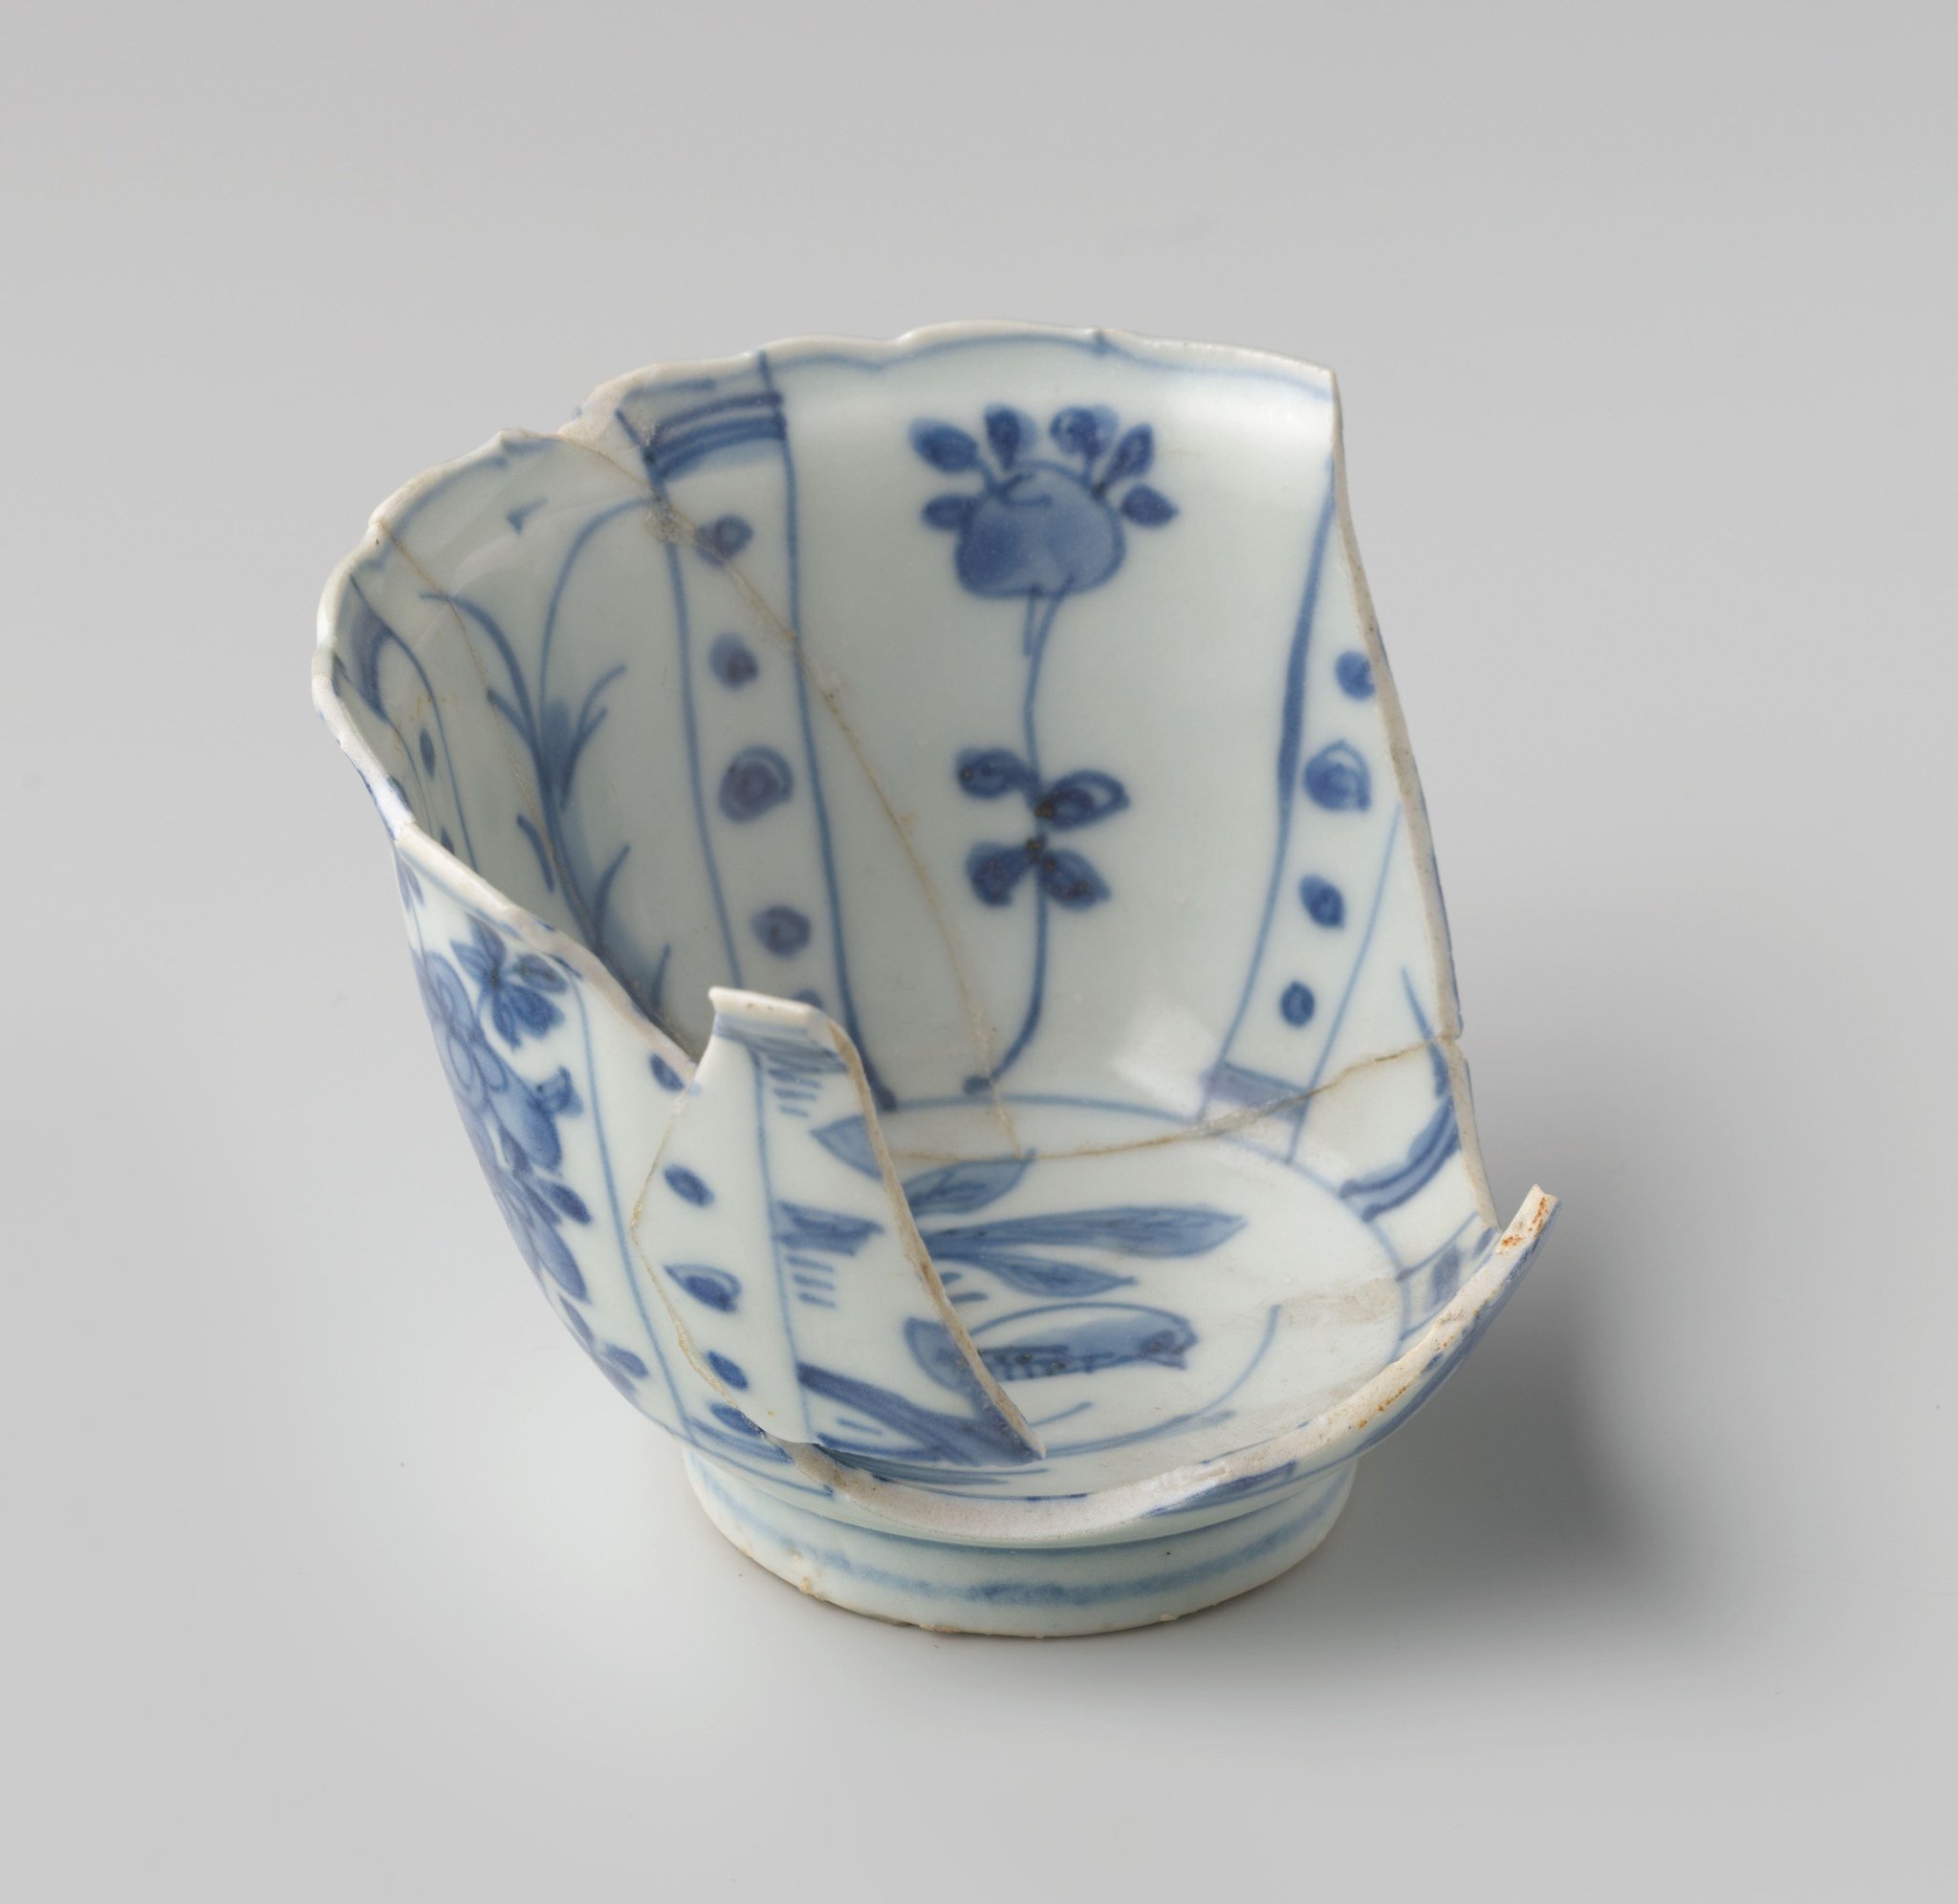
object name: bowl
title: Kom uit V.O.C.-schip de 'Witte Leeuw'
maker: Anonymous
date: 1613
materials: bone china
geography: jingdezhen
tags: verenigde oostindische compagnie, sint-helena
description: A high bowl. The interior panels are decorated with peach-sprays. and thorny branches. The exterior with flower- and peach-sprays. and bamboo.